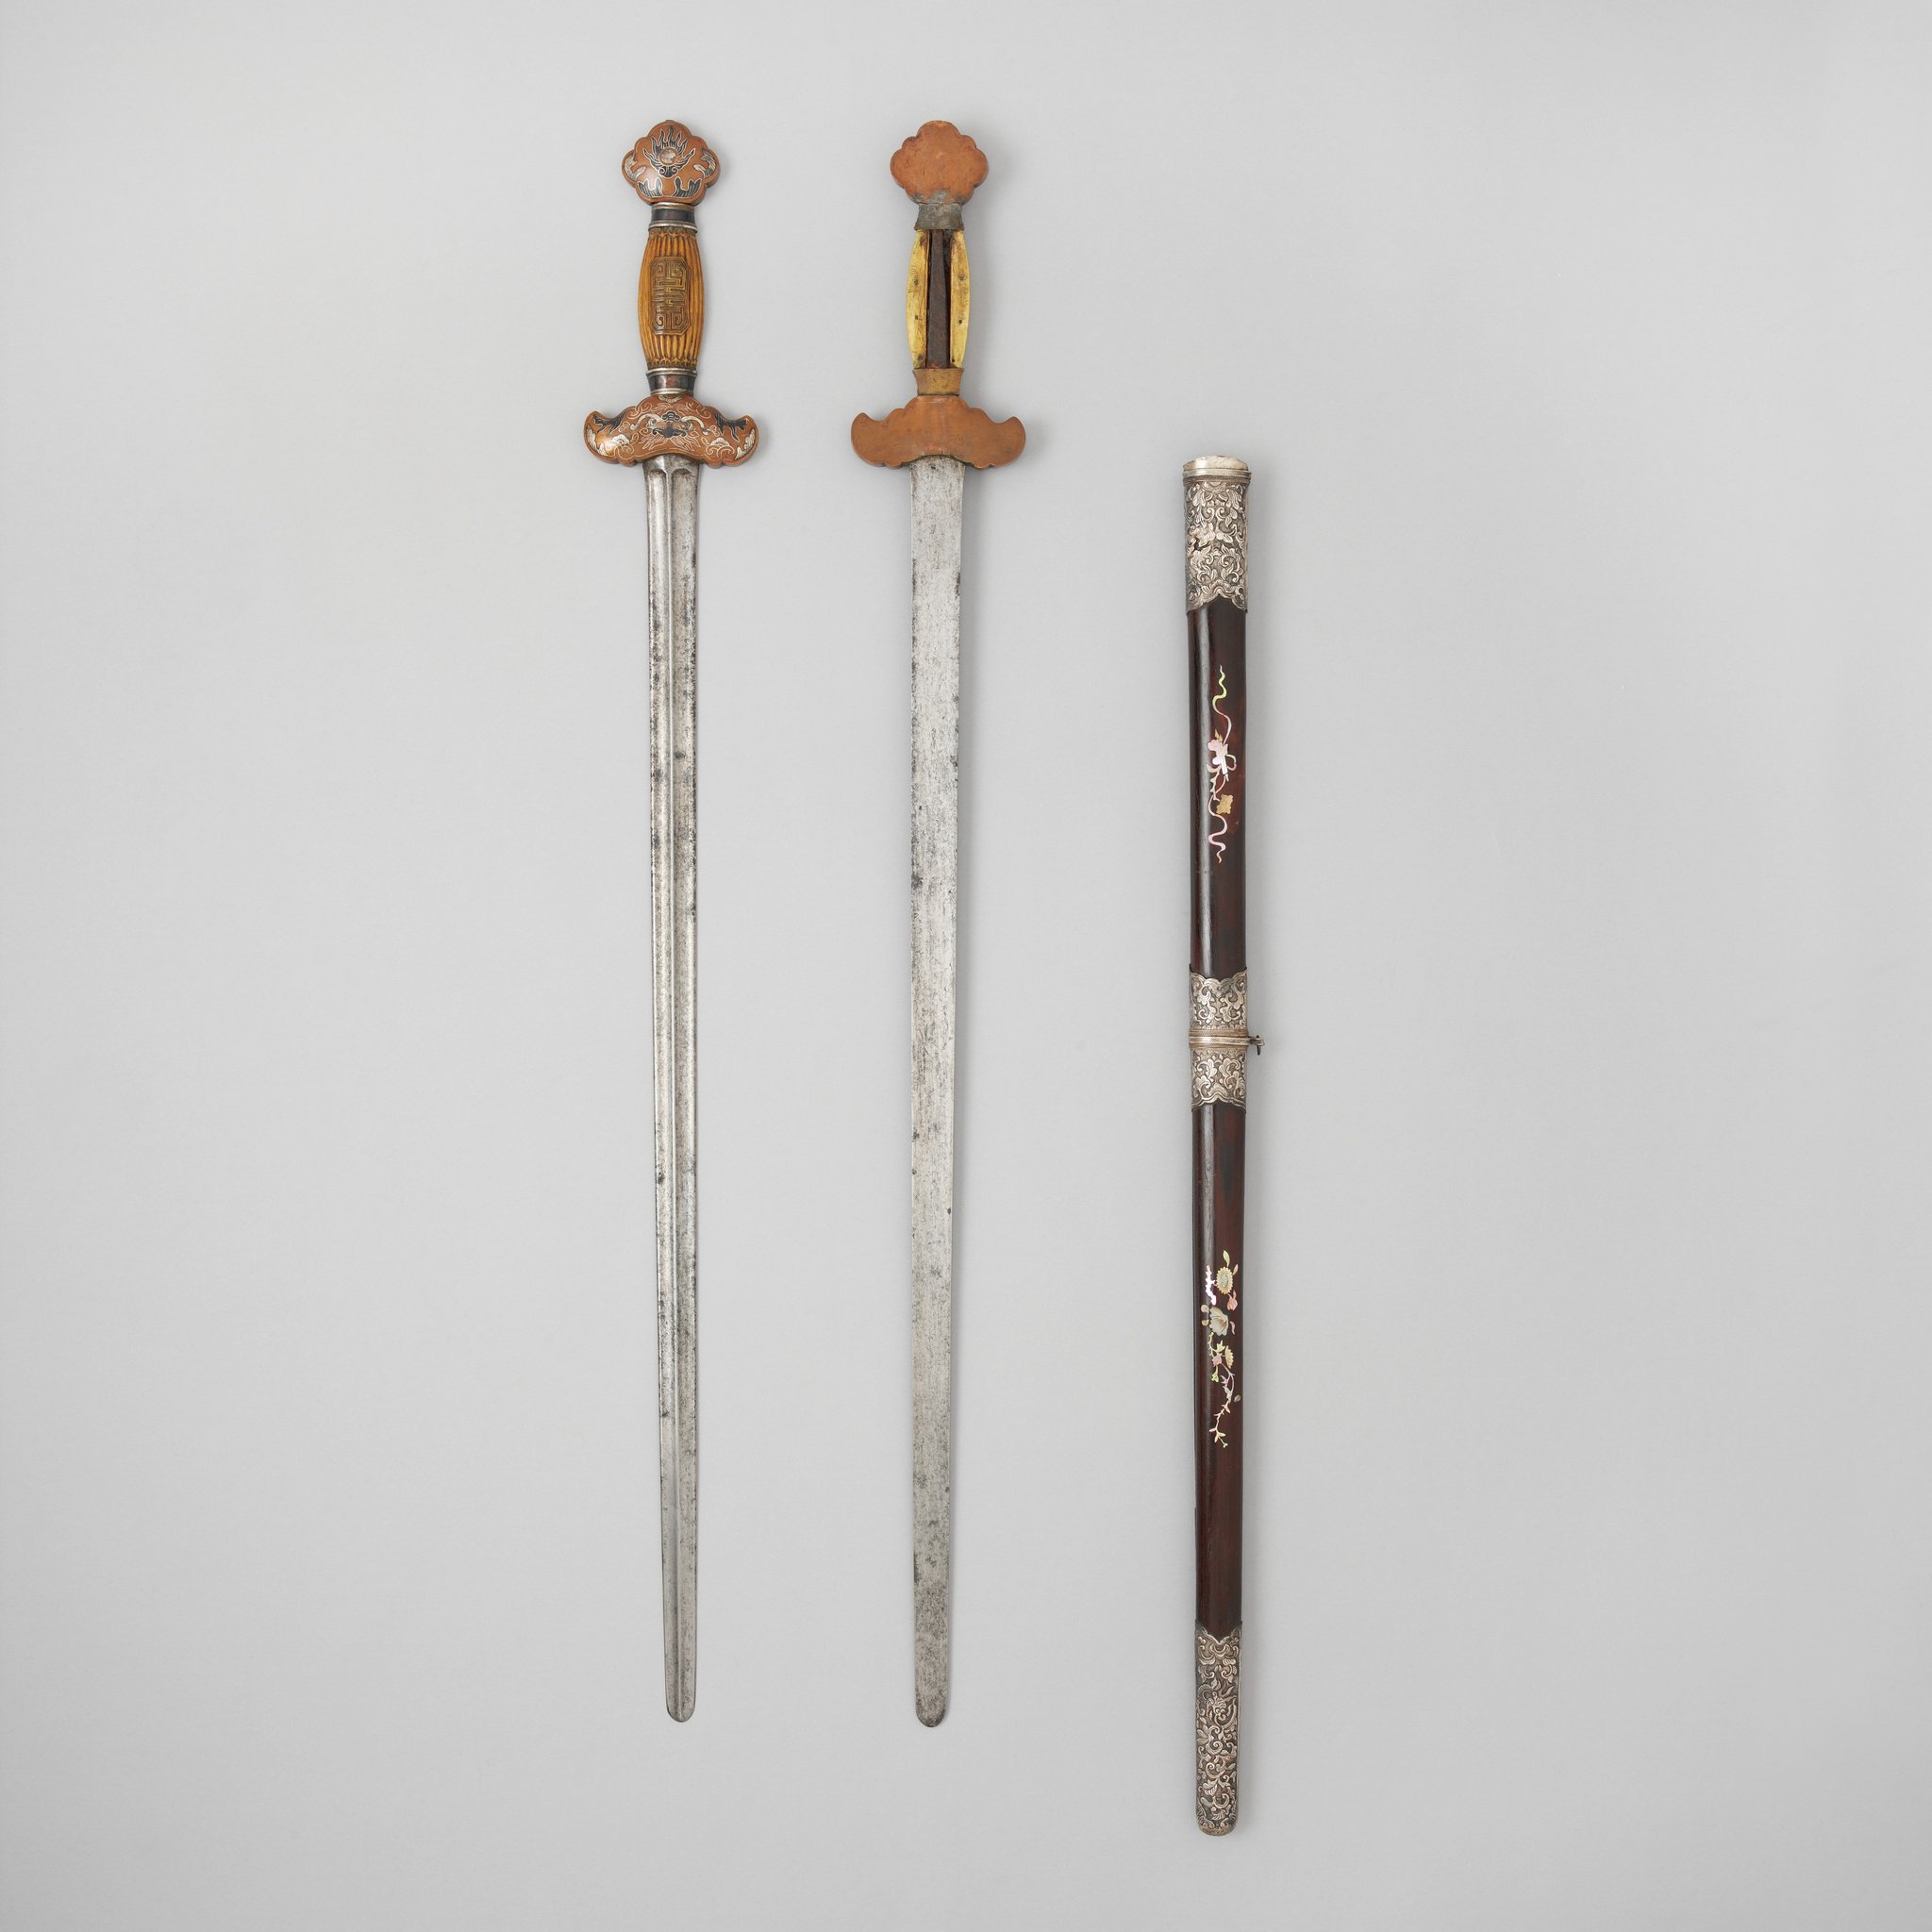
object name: double sword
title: Double Sword with Scabbard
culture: vietnamese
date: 1701-1900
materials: copper, ivory, mother of pearl, silver, steel, wood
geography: vietnam